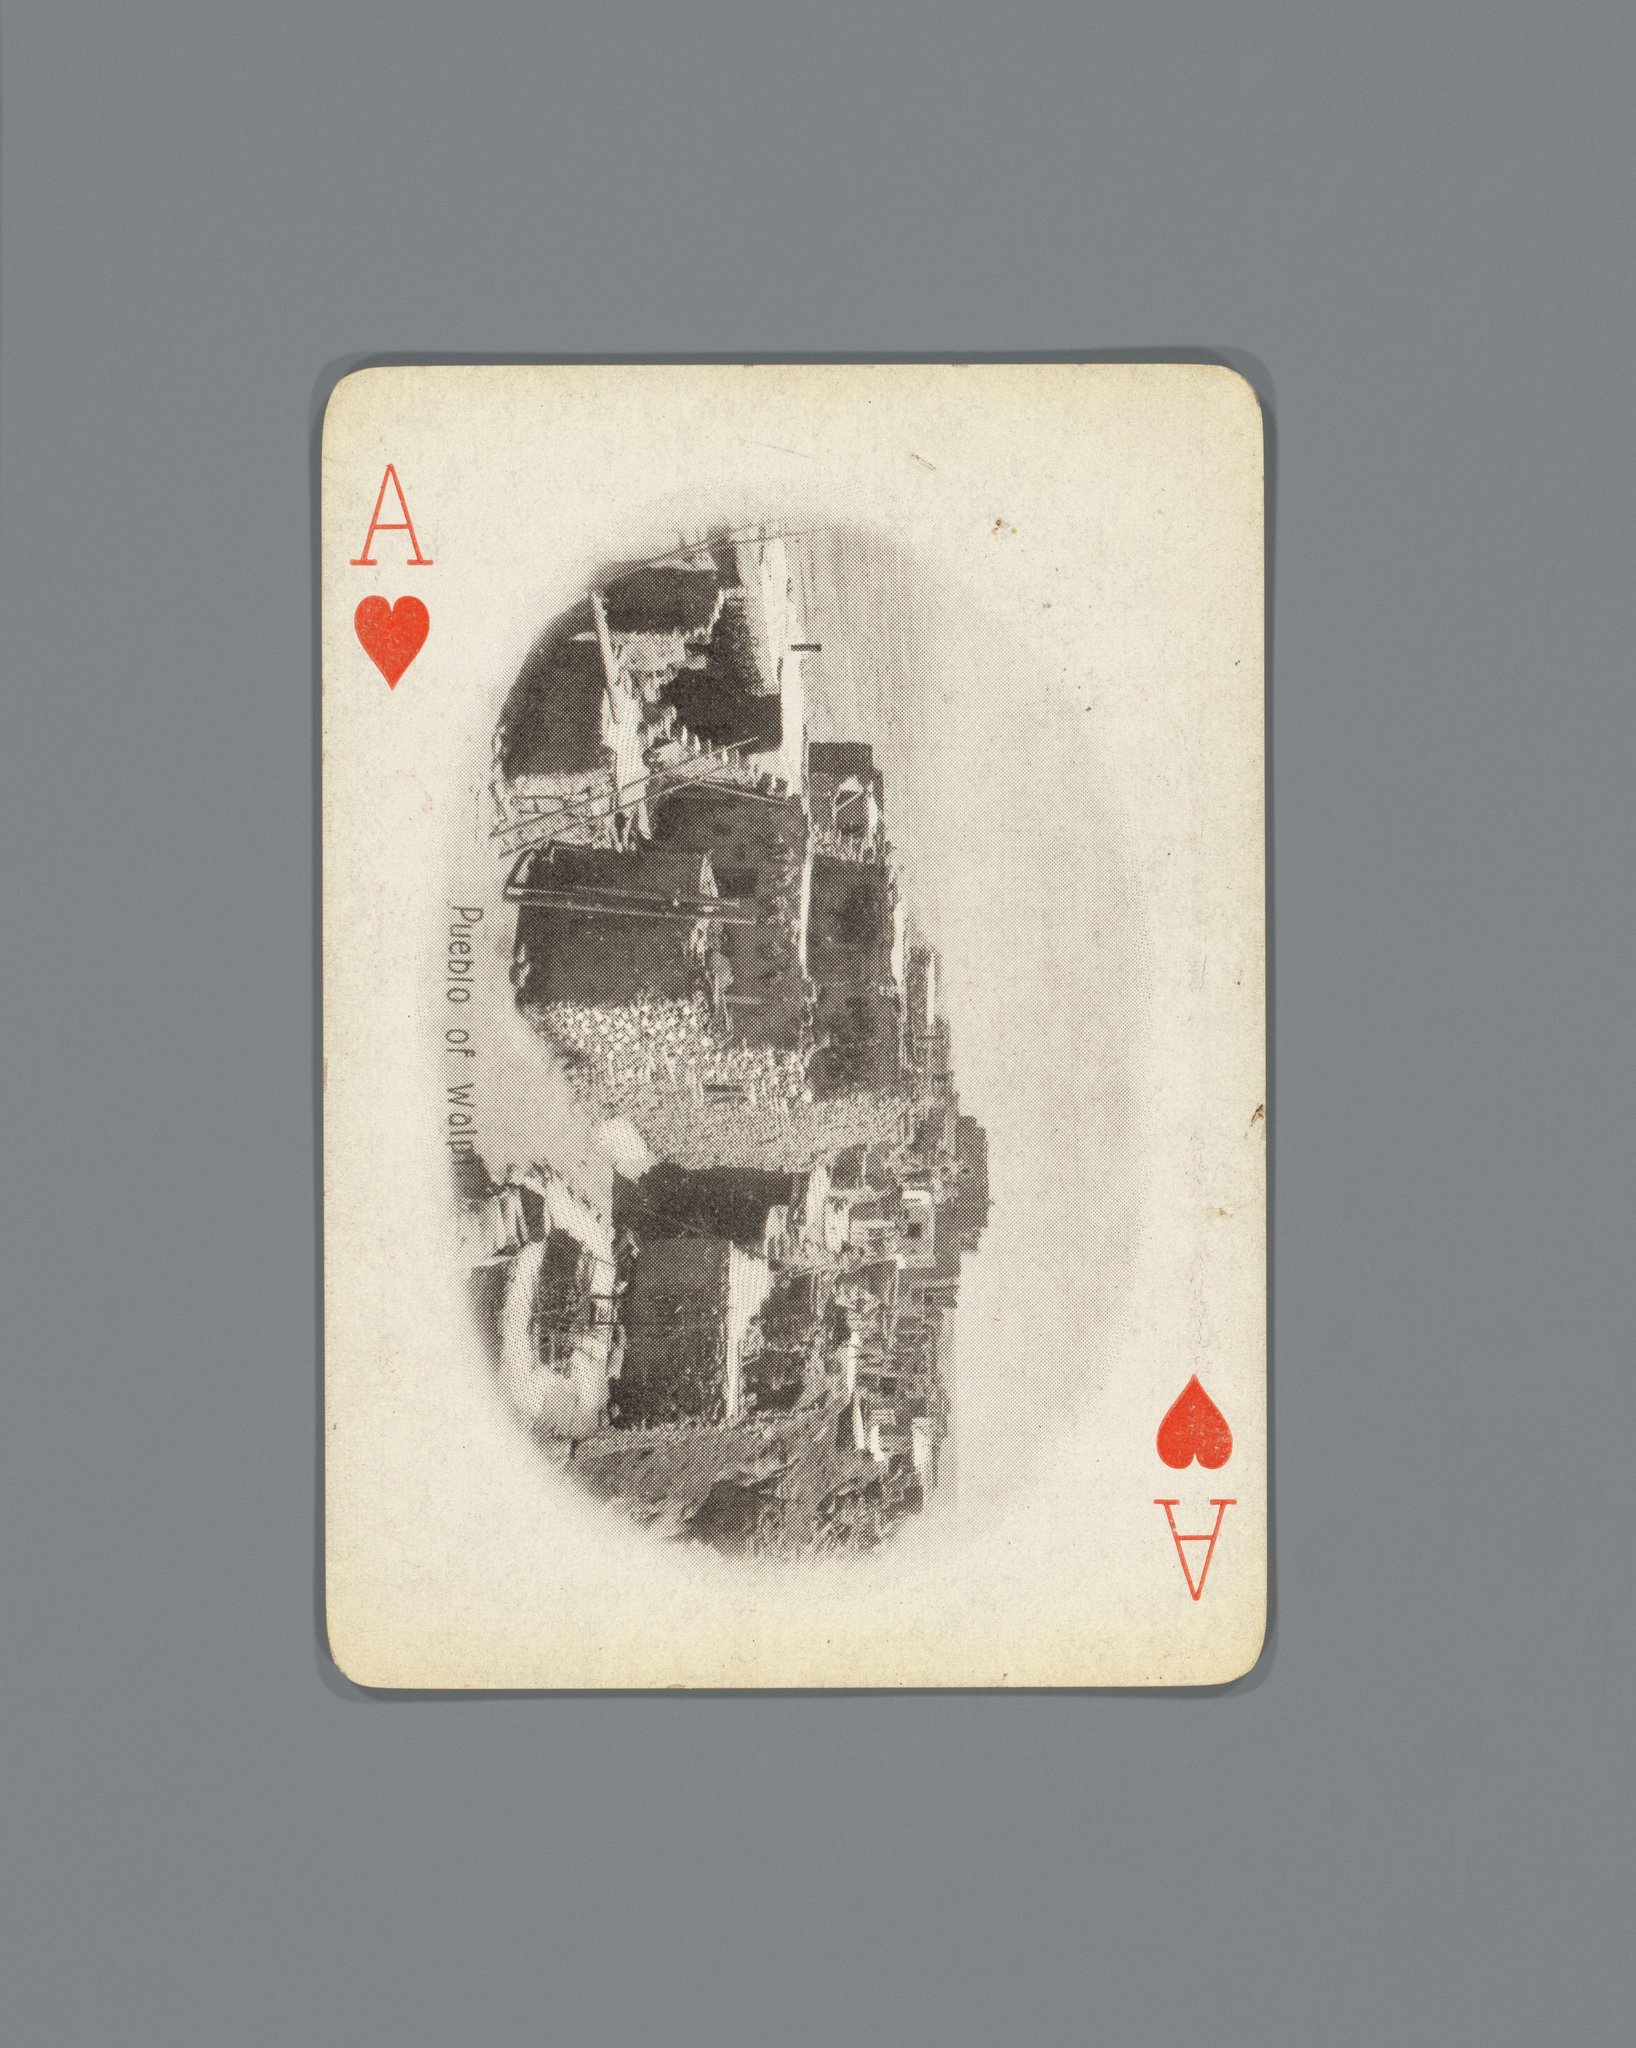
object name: playing card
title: Harten aas met gezicht op Walpi, een Hopidorp in Navajo County, Arizona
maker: adam clark vroman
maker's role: fotograaf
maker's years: 1856-1916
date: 1900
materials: paper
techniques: autotype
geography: los angeles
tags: arizona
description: Speelkaart uit doosje met 53 speelkaarten met afbeeldingen in autotypie van Native Americans. De inhoud bevat een complete set speelkaarten inclusief joker.